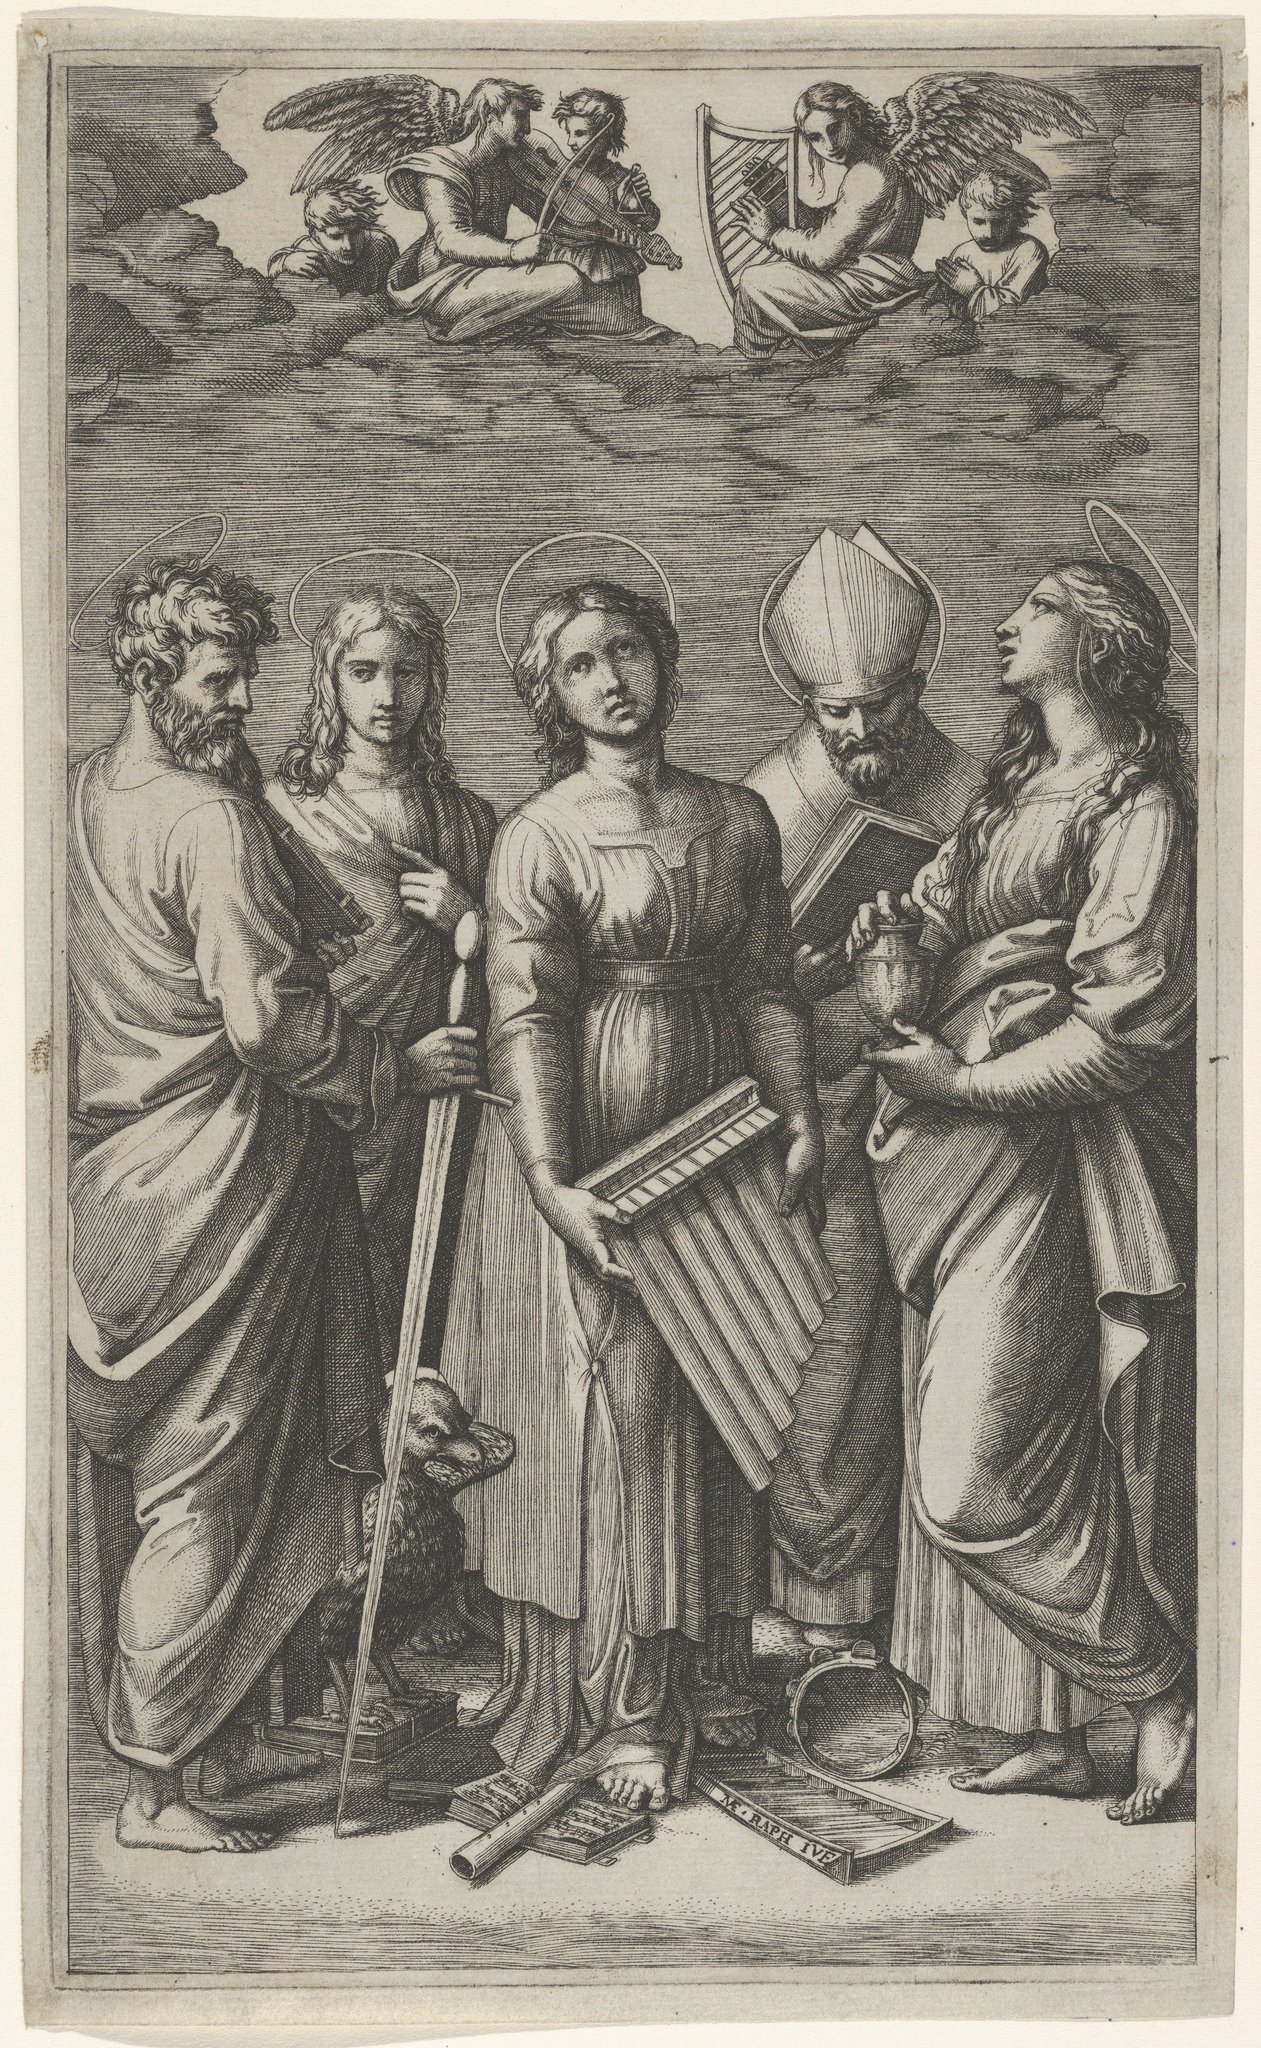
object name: print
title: St Cecilia holding an organ, flanked by St Paul, St John the Evangelist, St Augustine and Mary Magdalen, musical angels above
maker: marcantonio raimondi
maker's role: artist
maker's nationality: italian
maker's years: 1475-1534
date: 1515-1516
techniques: engraving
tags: harps,angels,mary magdalene,saint john the evangelist,saint paul